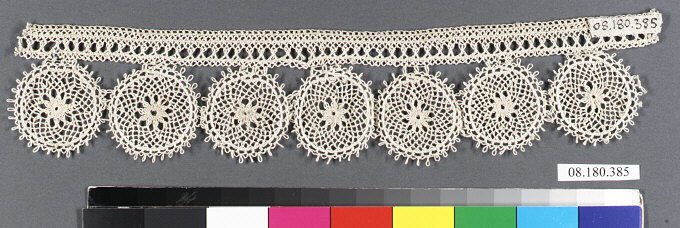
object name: fragment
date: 1801-1900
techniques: embroidery